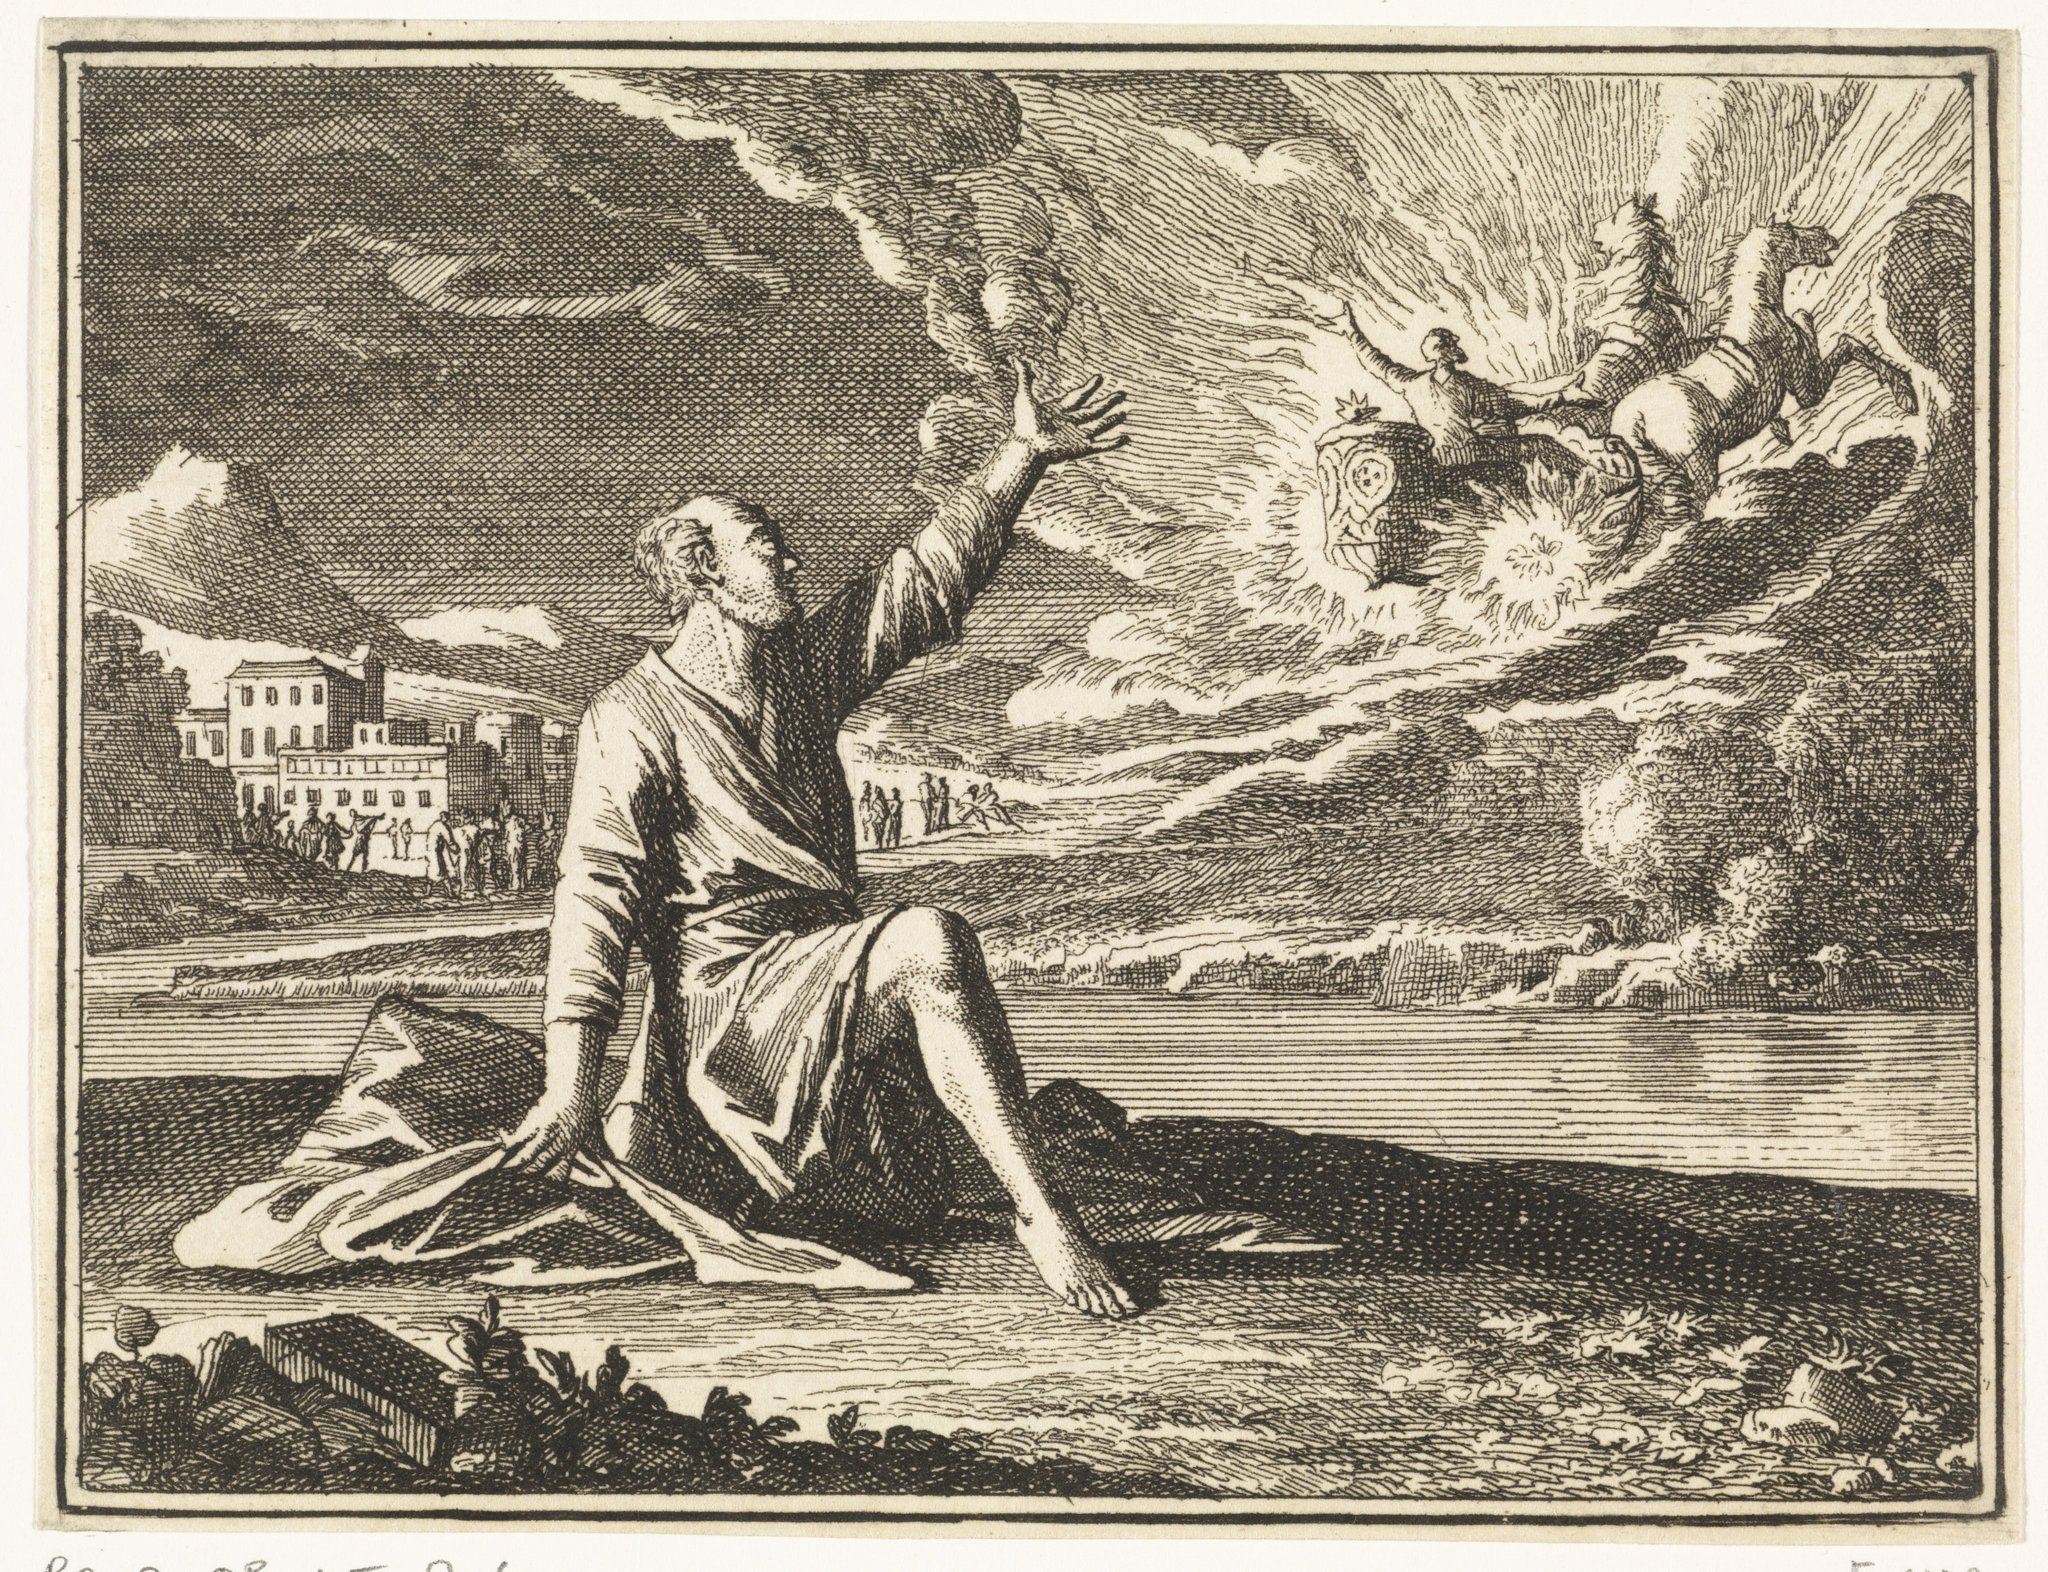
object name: print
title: Hemelvaart van Elia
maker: caspar luyken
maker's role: draughtsman, print maker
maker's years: 1672-1708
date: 1712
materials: paper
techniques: etching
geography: amsterdam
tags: the ascension of elijah (2 kings 2:1-18)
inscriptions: collector's mark: Lugt 2228, number: ‘142’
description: Illustratie uit: Luyken, Jan. De schriftuurlyke geschiedenissen en gelykenissen van het Oude en Nieuwe Verbond, 2 delen. Amsterdam: Wed. Pieter Arentsz II en Cornelis van der Sys, 1712, dl. I.